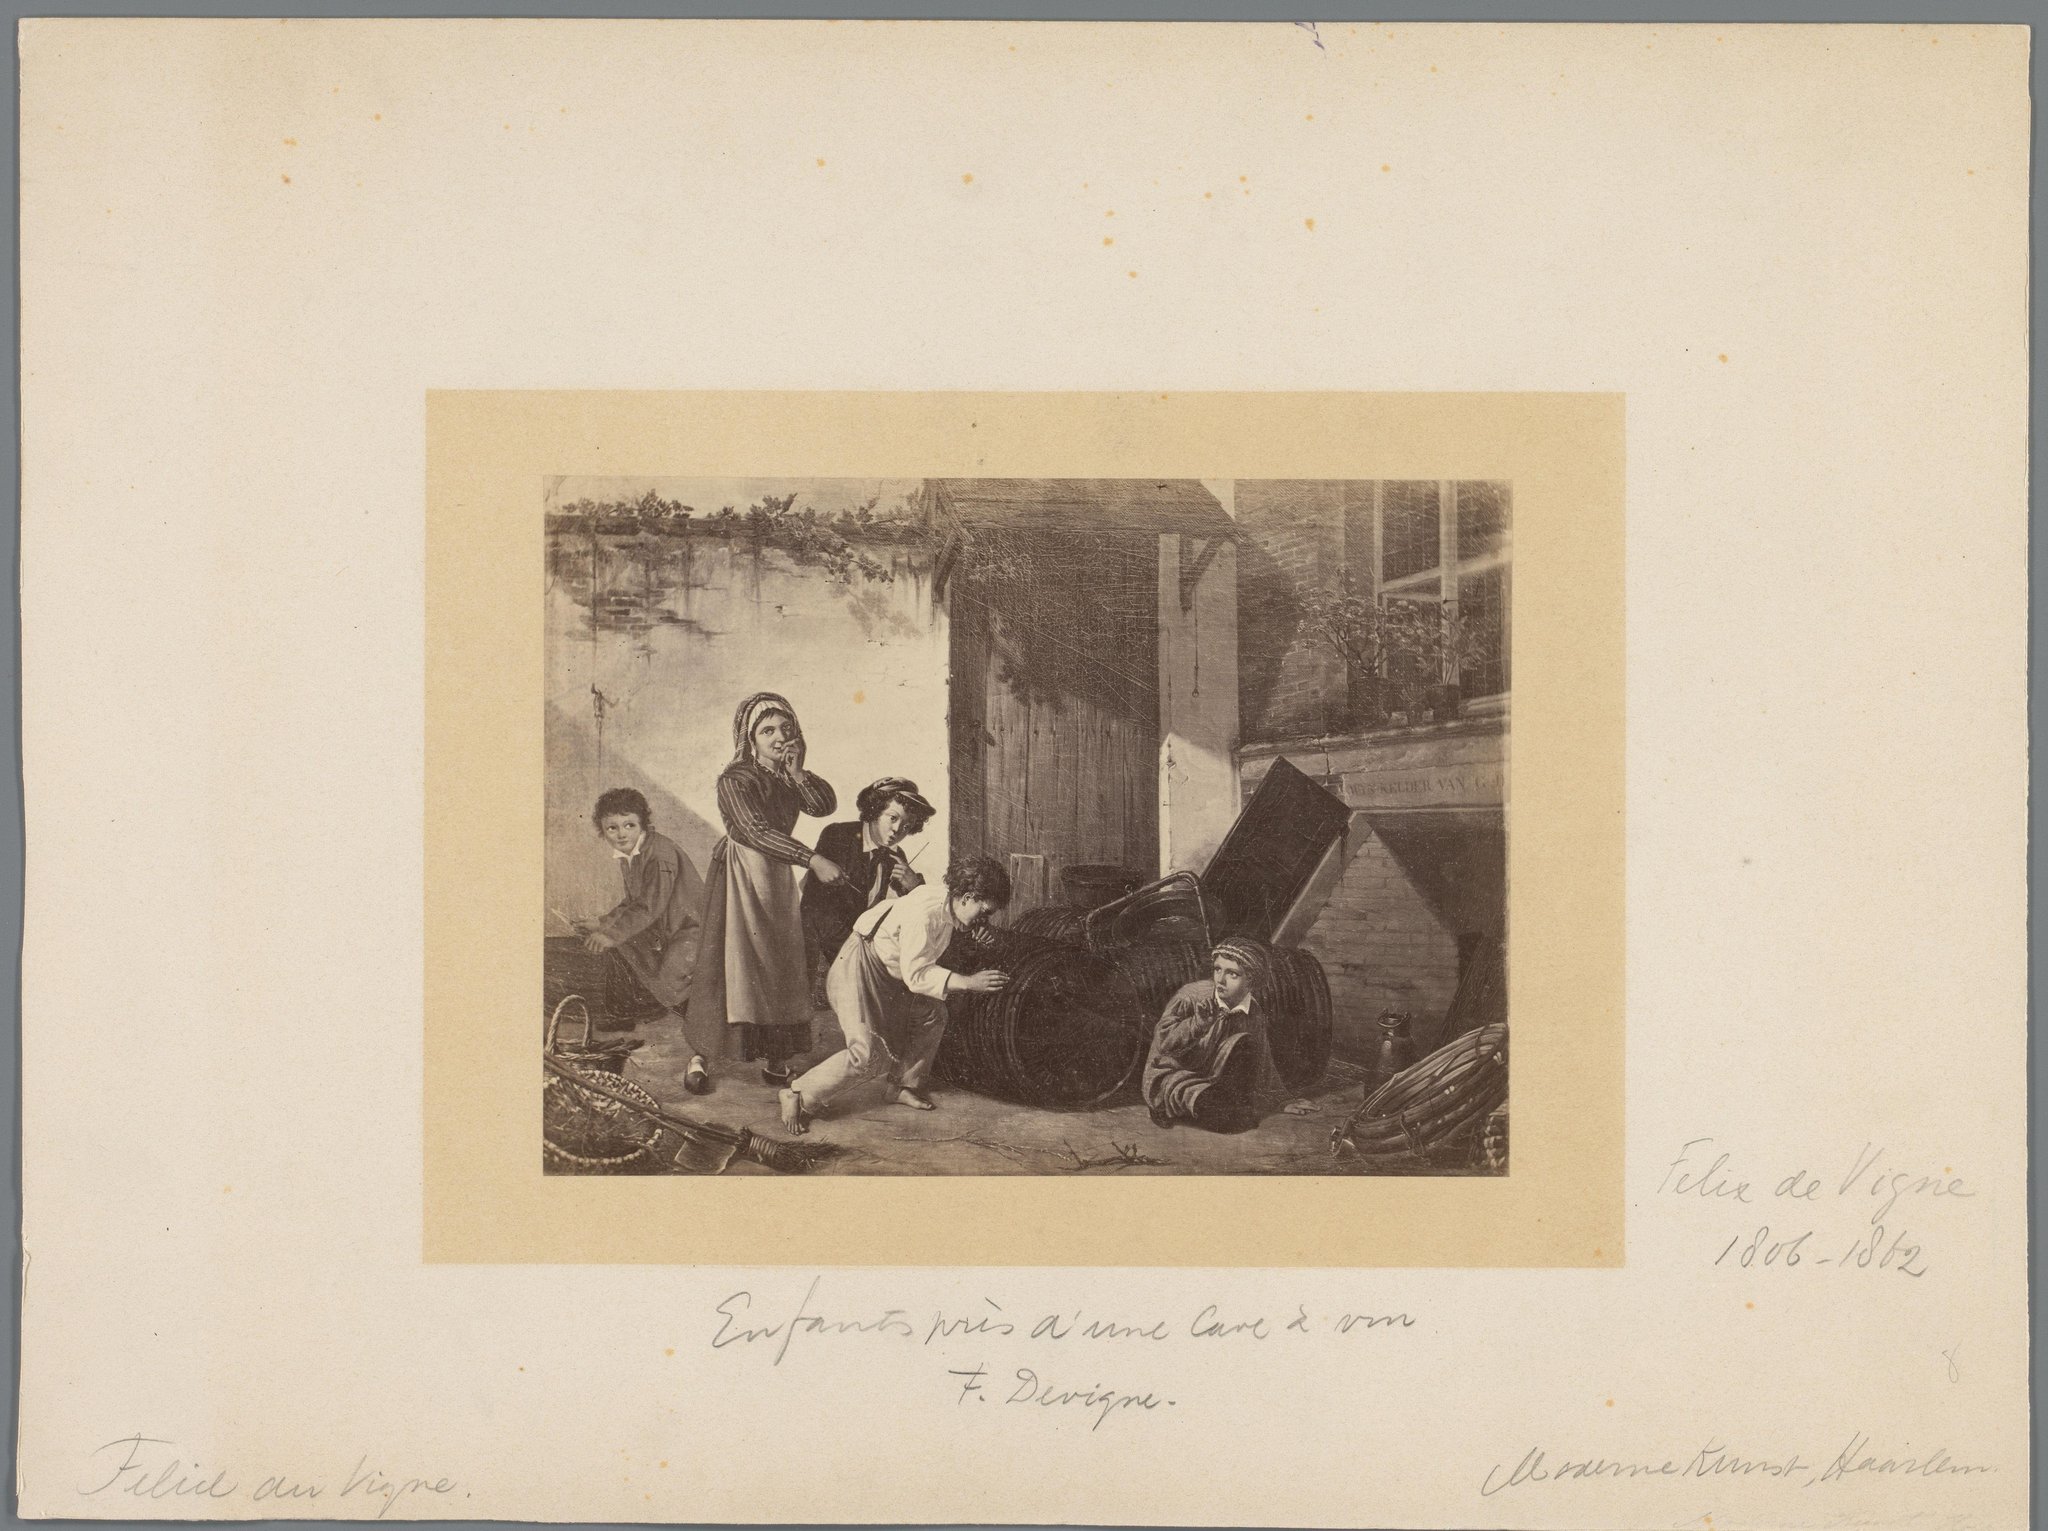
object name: photograph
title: Enfants près d'une cave à vin, F. Devigne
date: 1880-1900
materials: paper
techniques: albumen print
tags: wooden container: barrel, cask, bucket, children's games and plays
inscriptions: inscription: ‘Felix du Vigne/ Felix de Vigne/ 1806-1862/ Moderne Kunst, Haarlem’